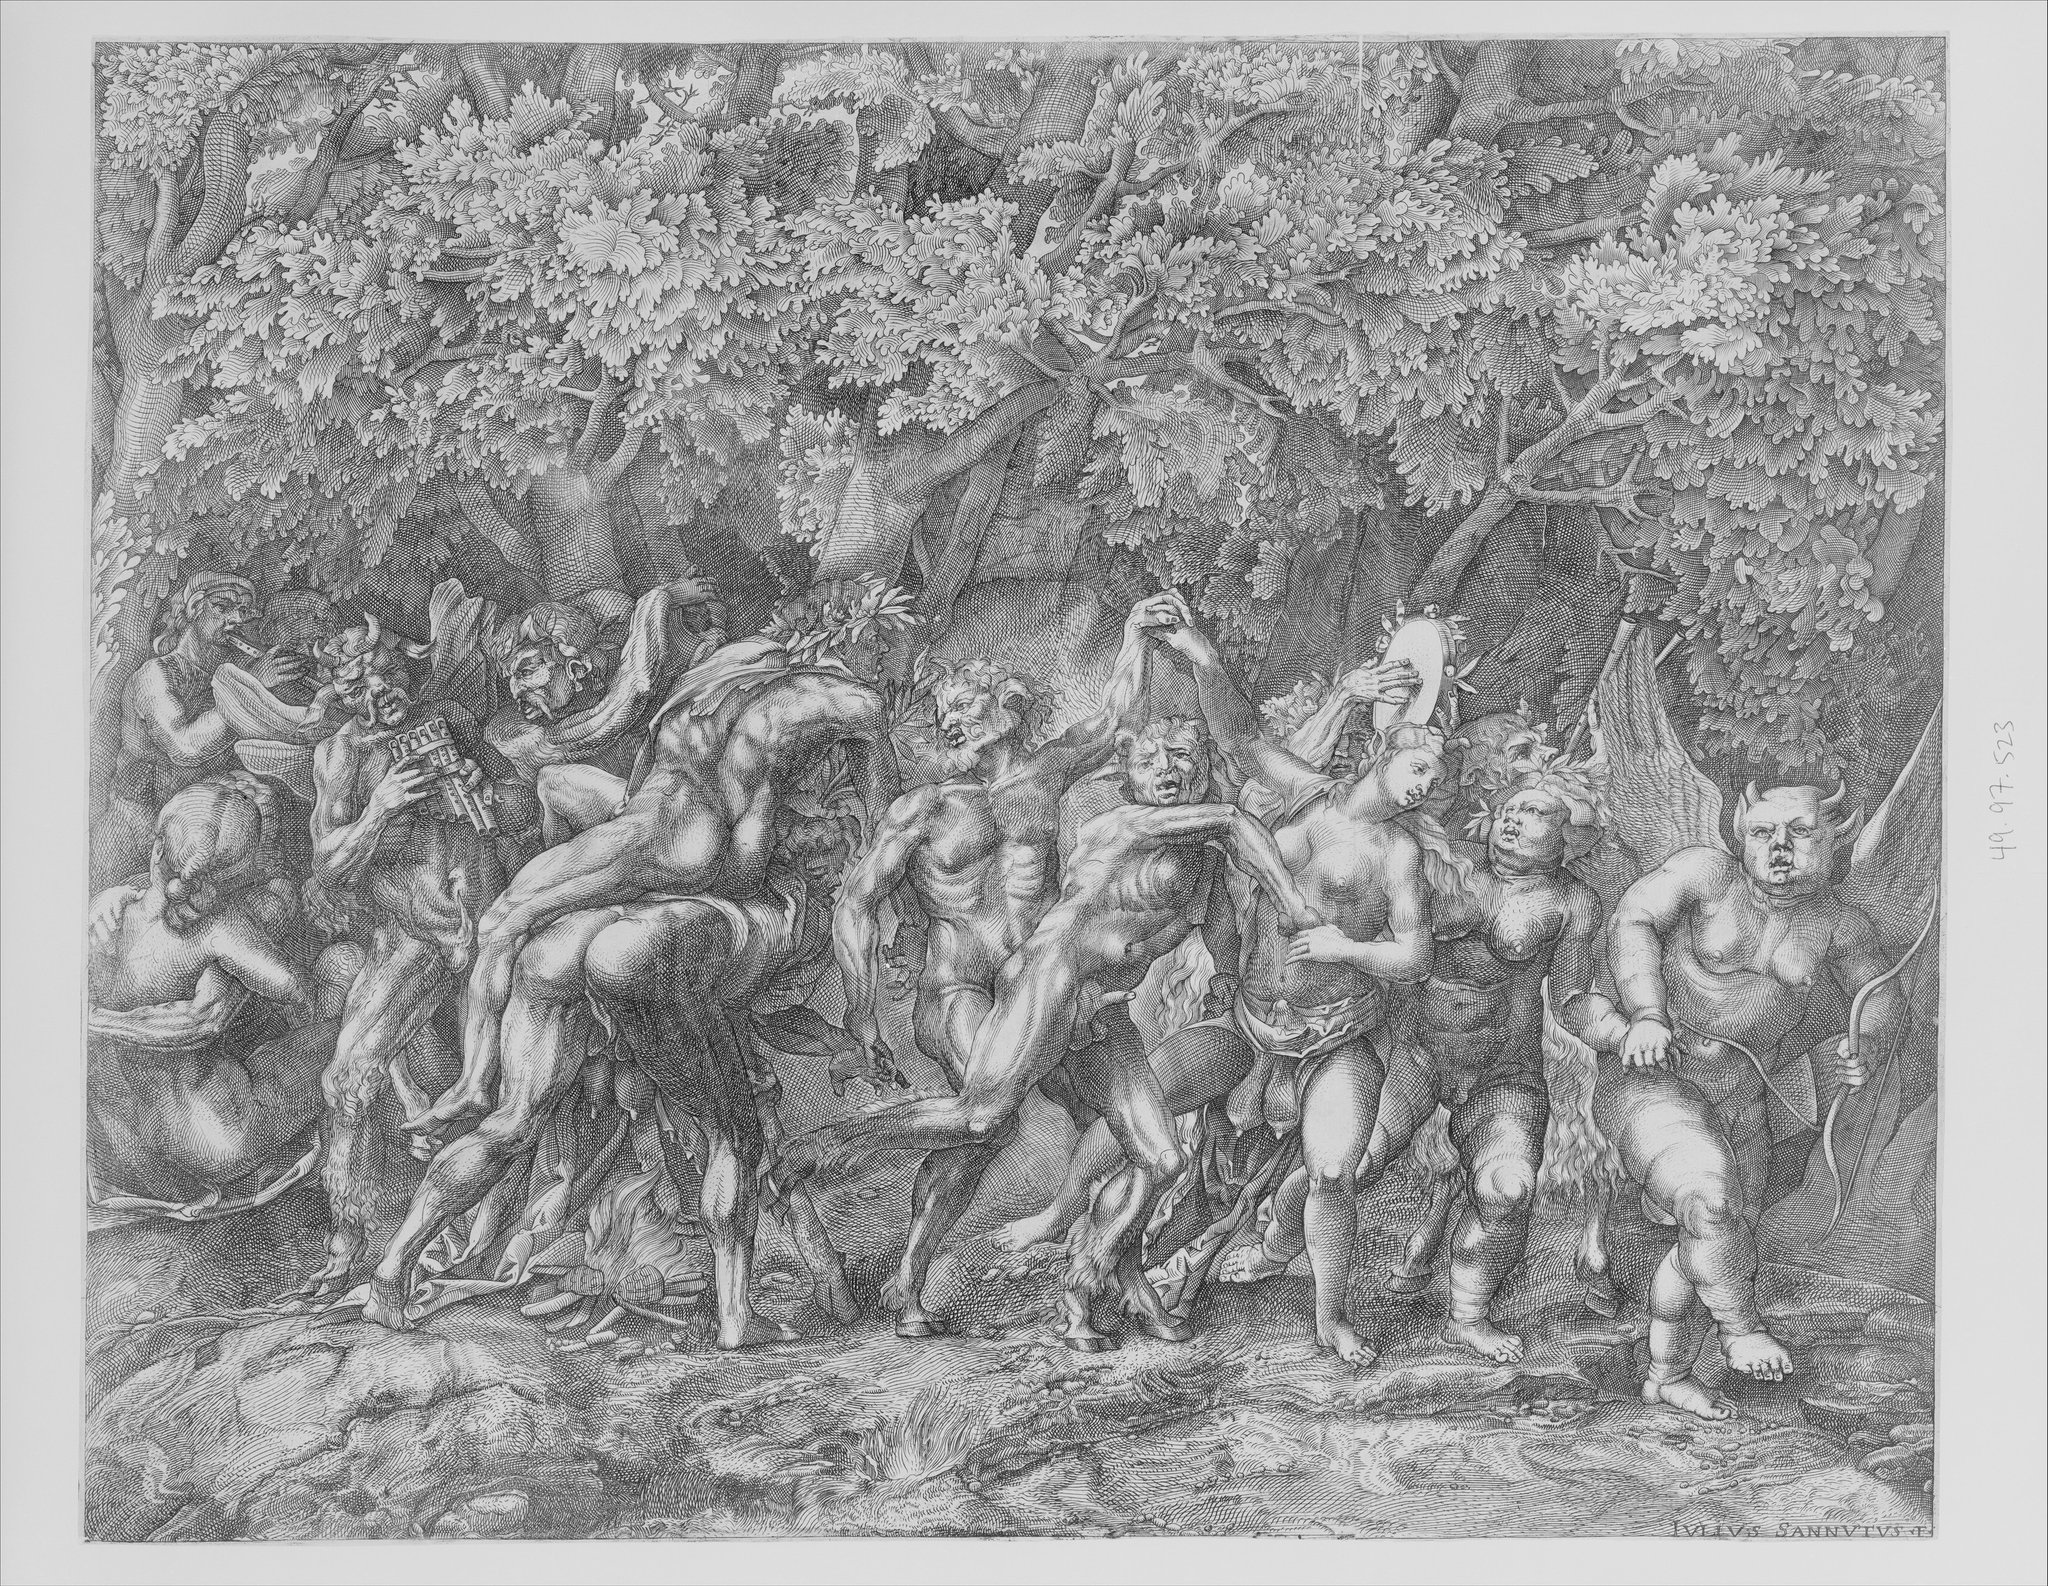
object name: print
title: Bacchanal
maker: giulio sanuto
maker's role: artist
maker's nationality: italian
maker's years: 1540-1588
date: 1557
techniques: engraving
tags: musical instruments,drunkenness,satyrs,demons